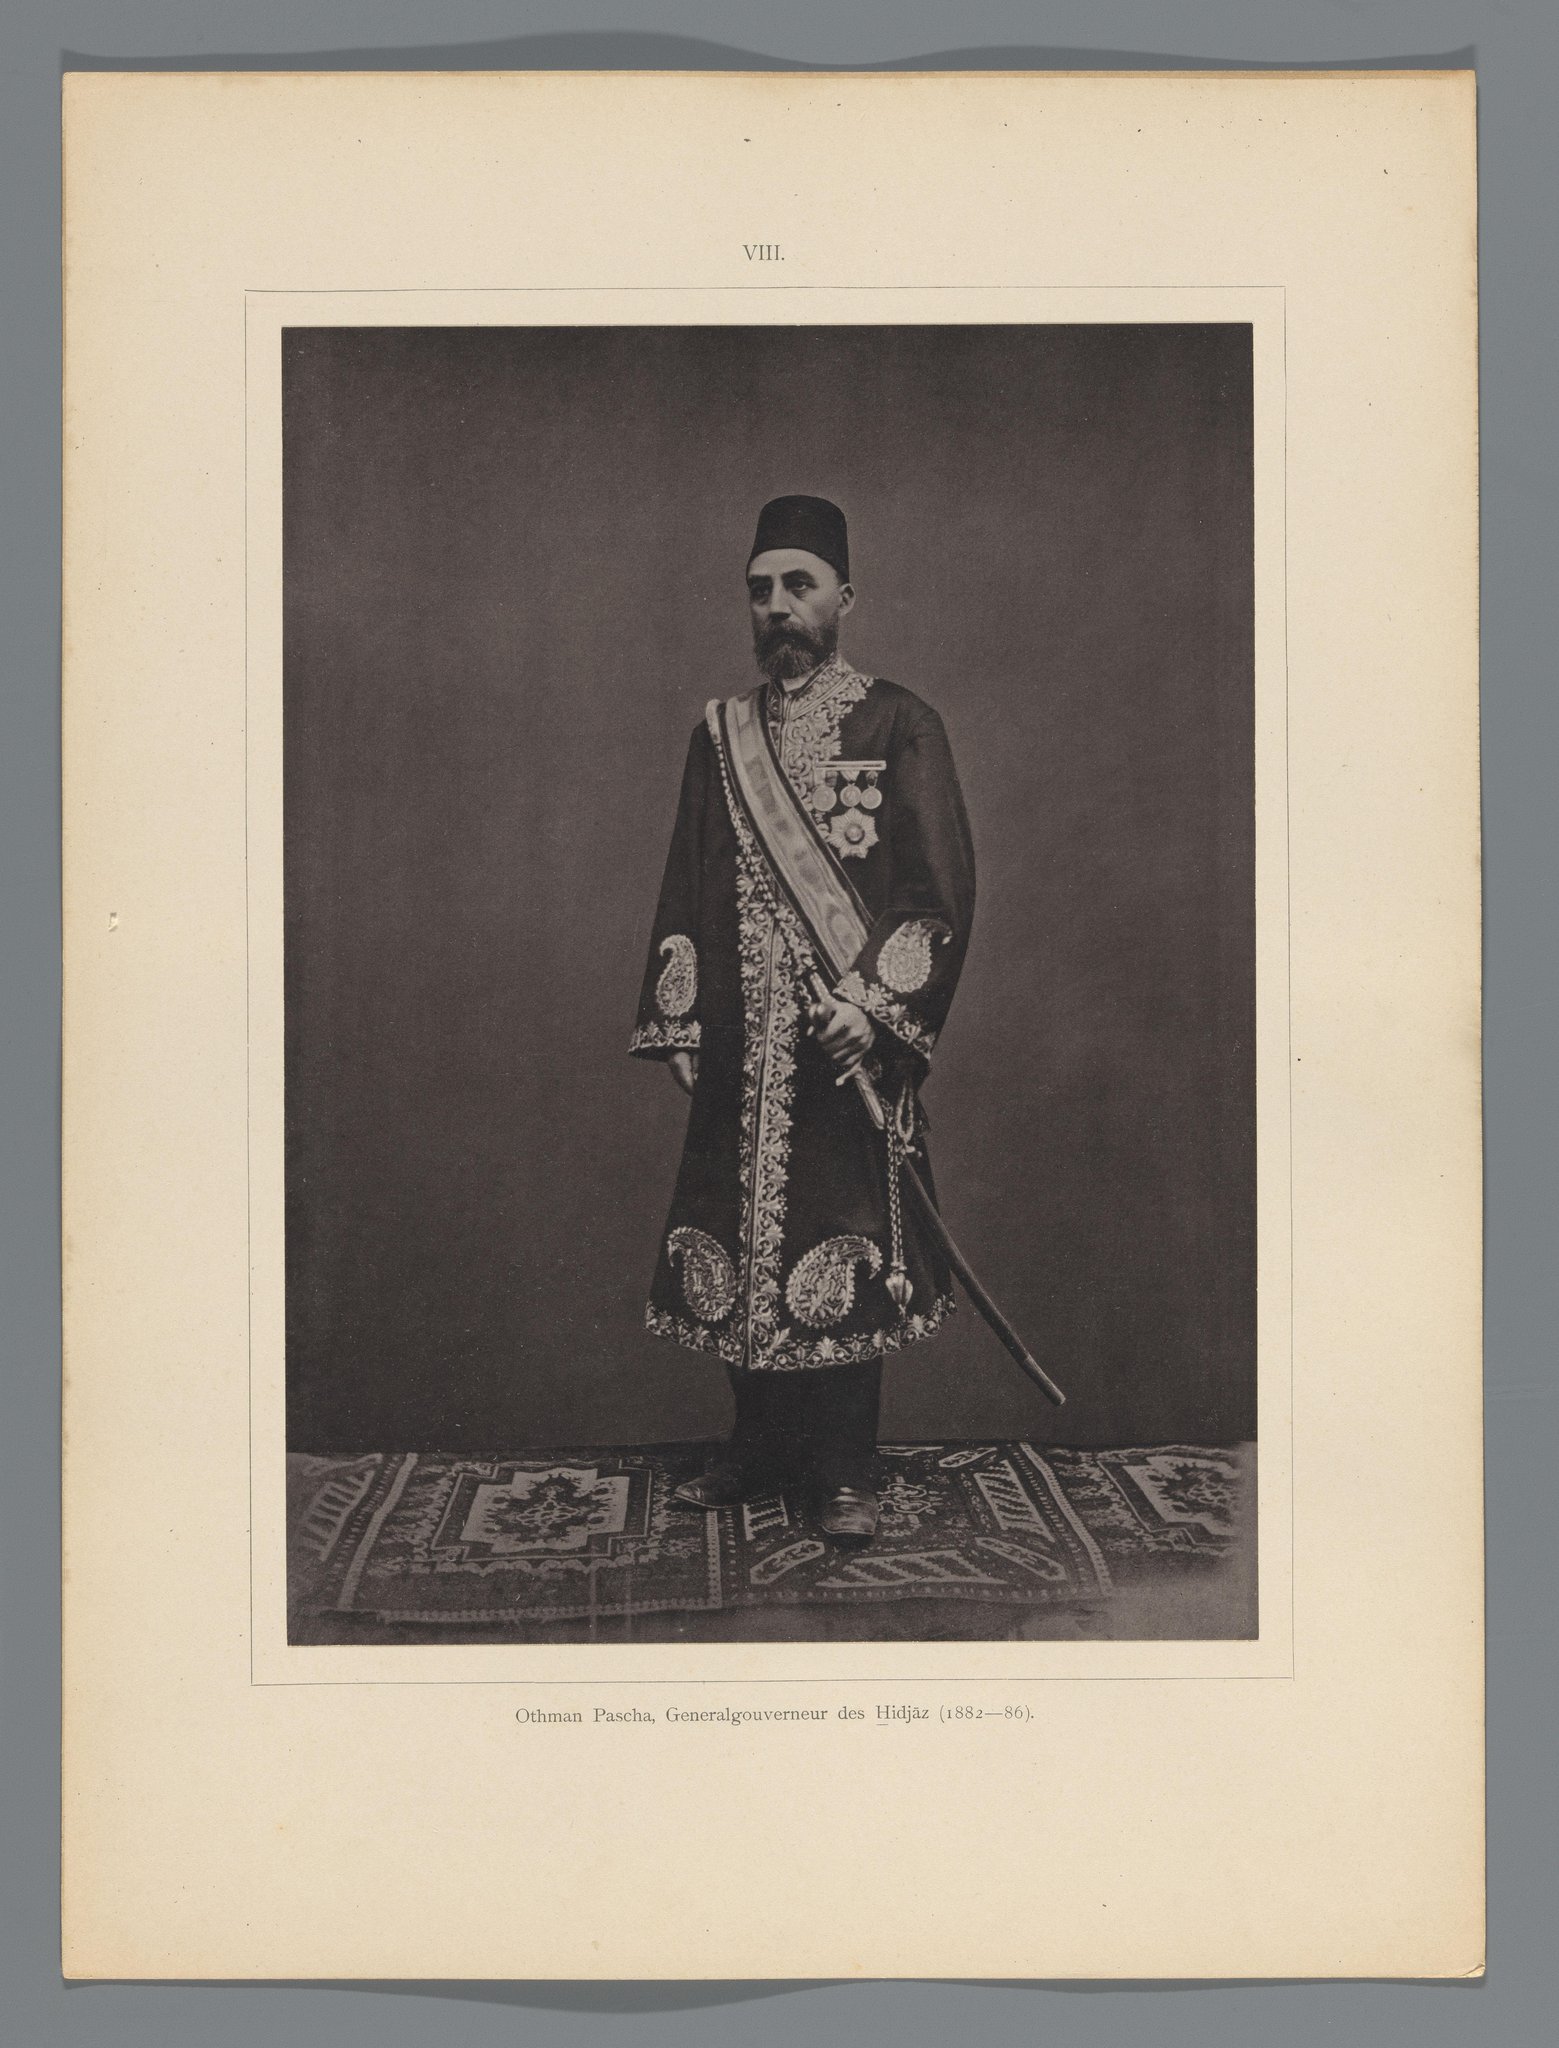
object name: photomechanical print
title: Portret van de Turkse gouverneur van de Hidjaz, Othman Nuri Pasja, te Mekka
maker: Anonymous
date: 1885-1888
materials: paper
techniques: photograph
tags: historical persons, governor, etc. of province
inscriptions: number: ‘VIII.’